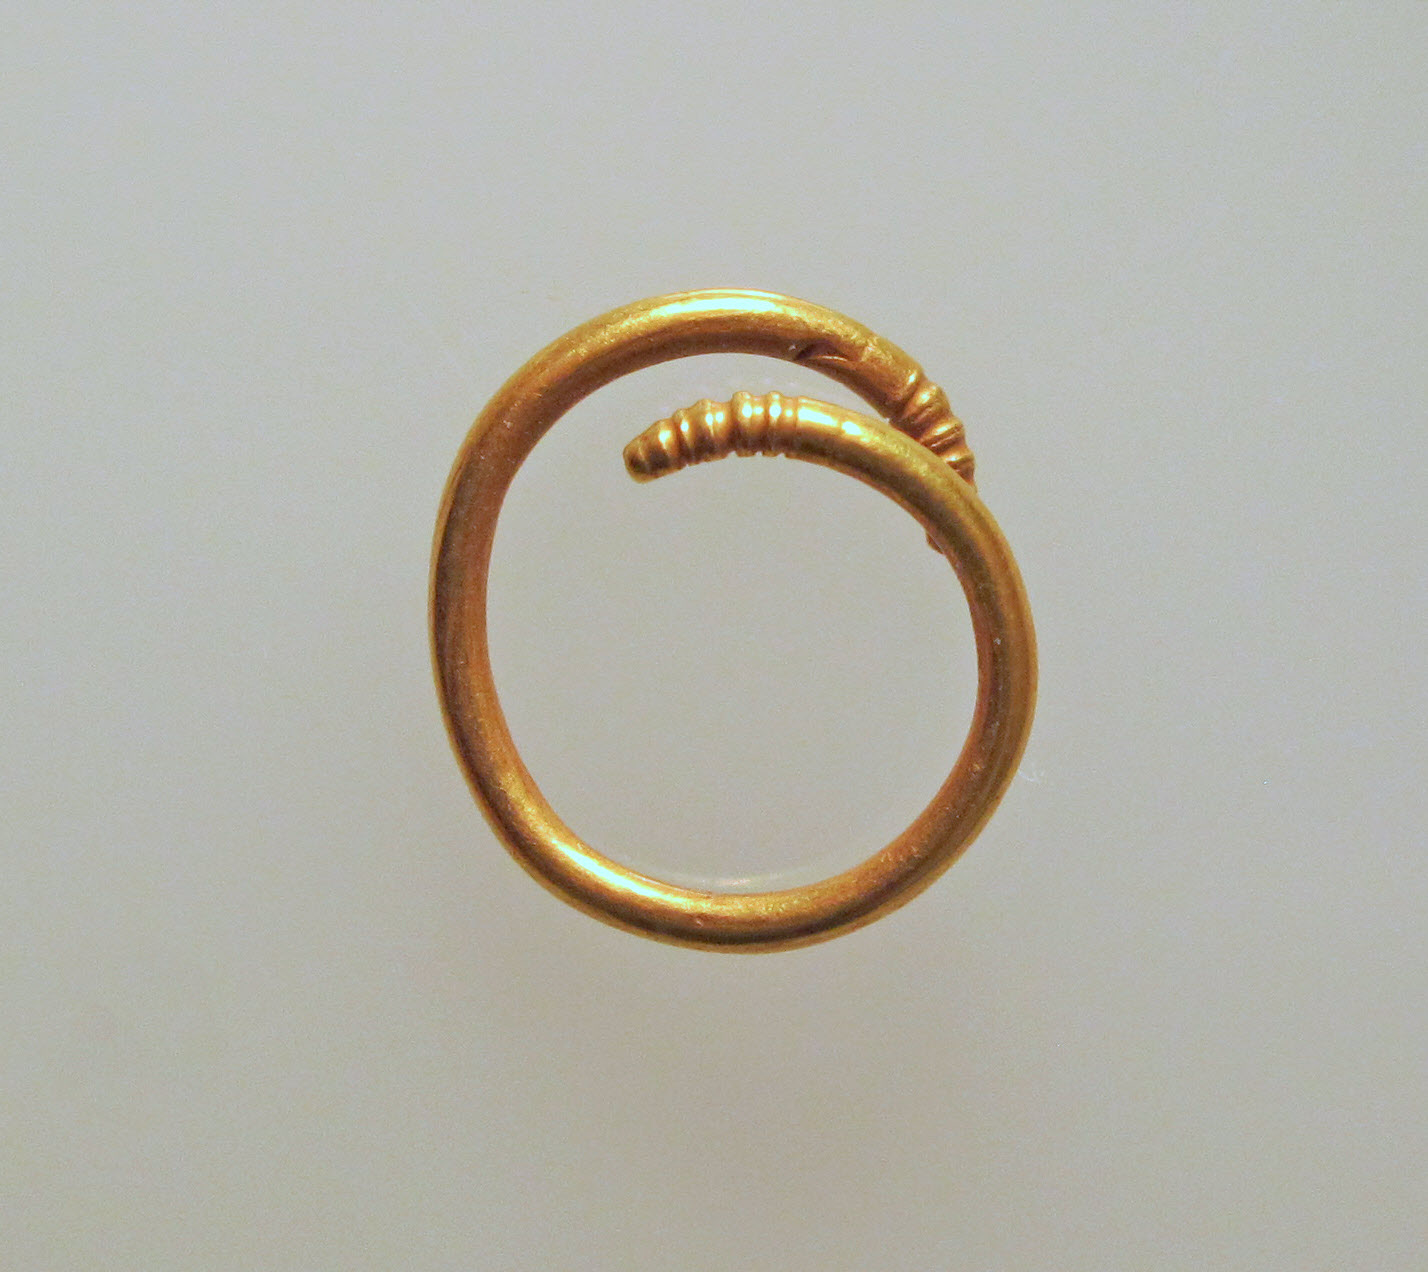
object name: spiral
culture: cypriot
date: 3900 BCE-100 CE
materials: gold